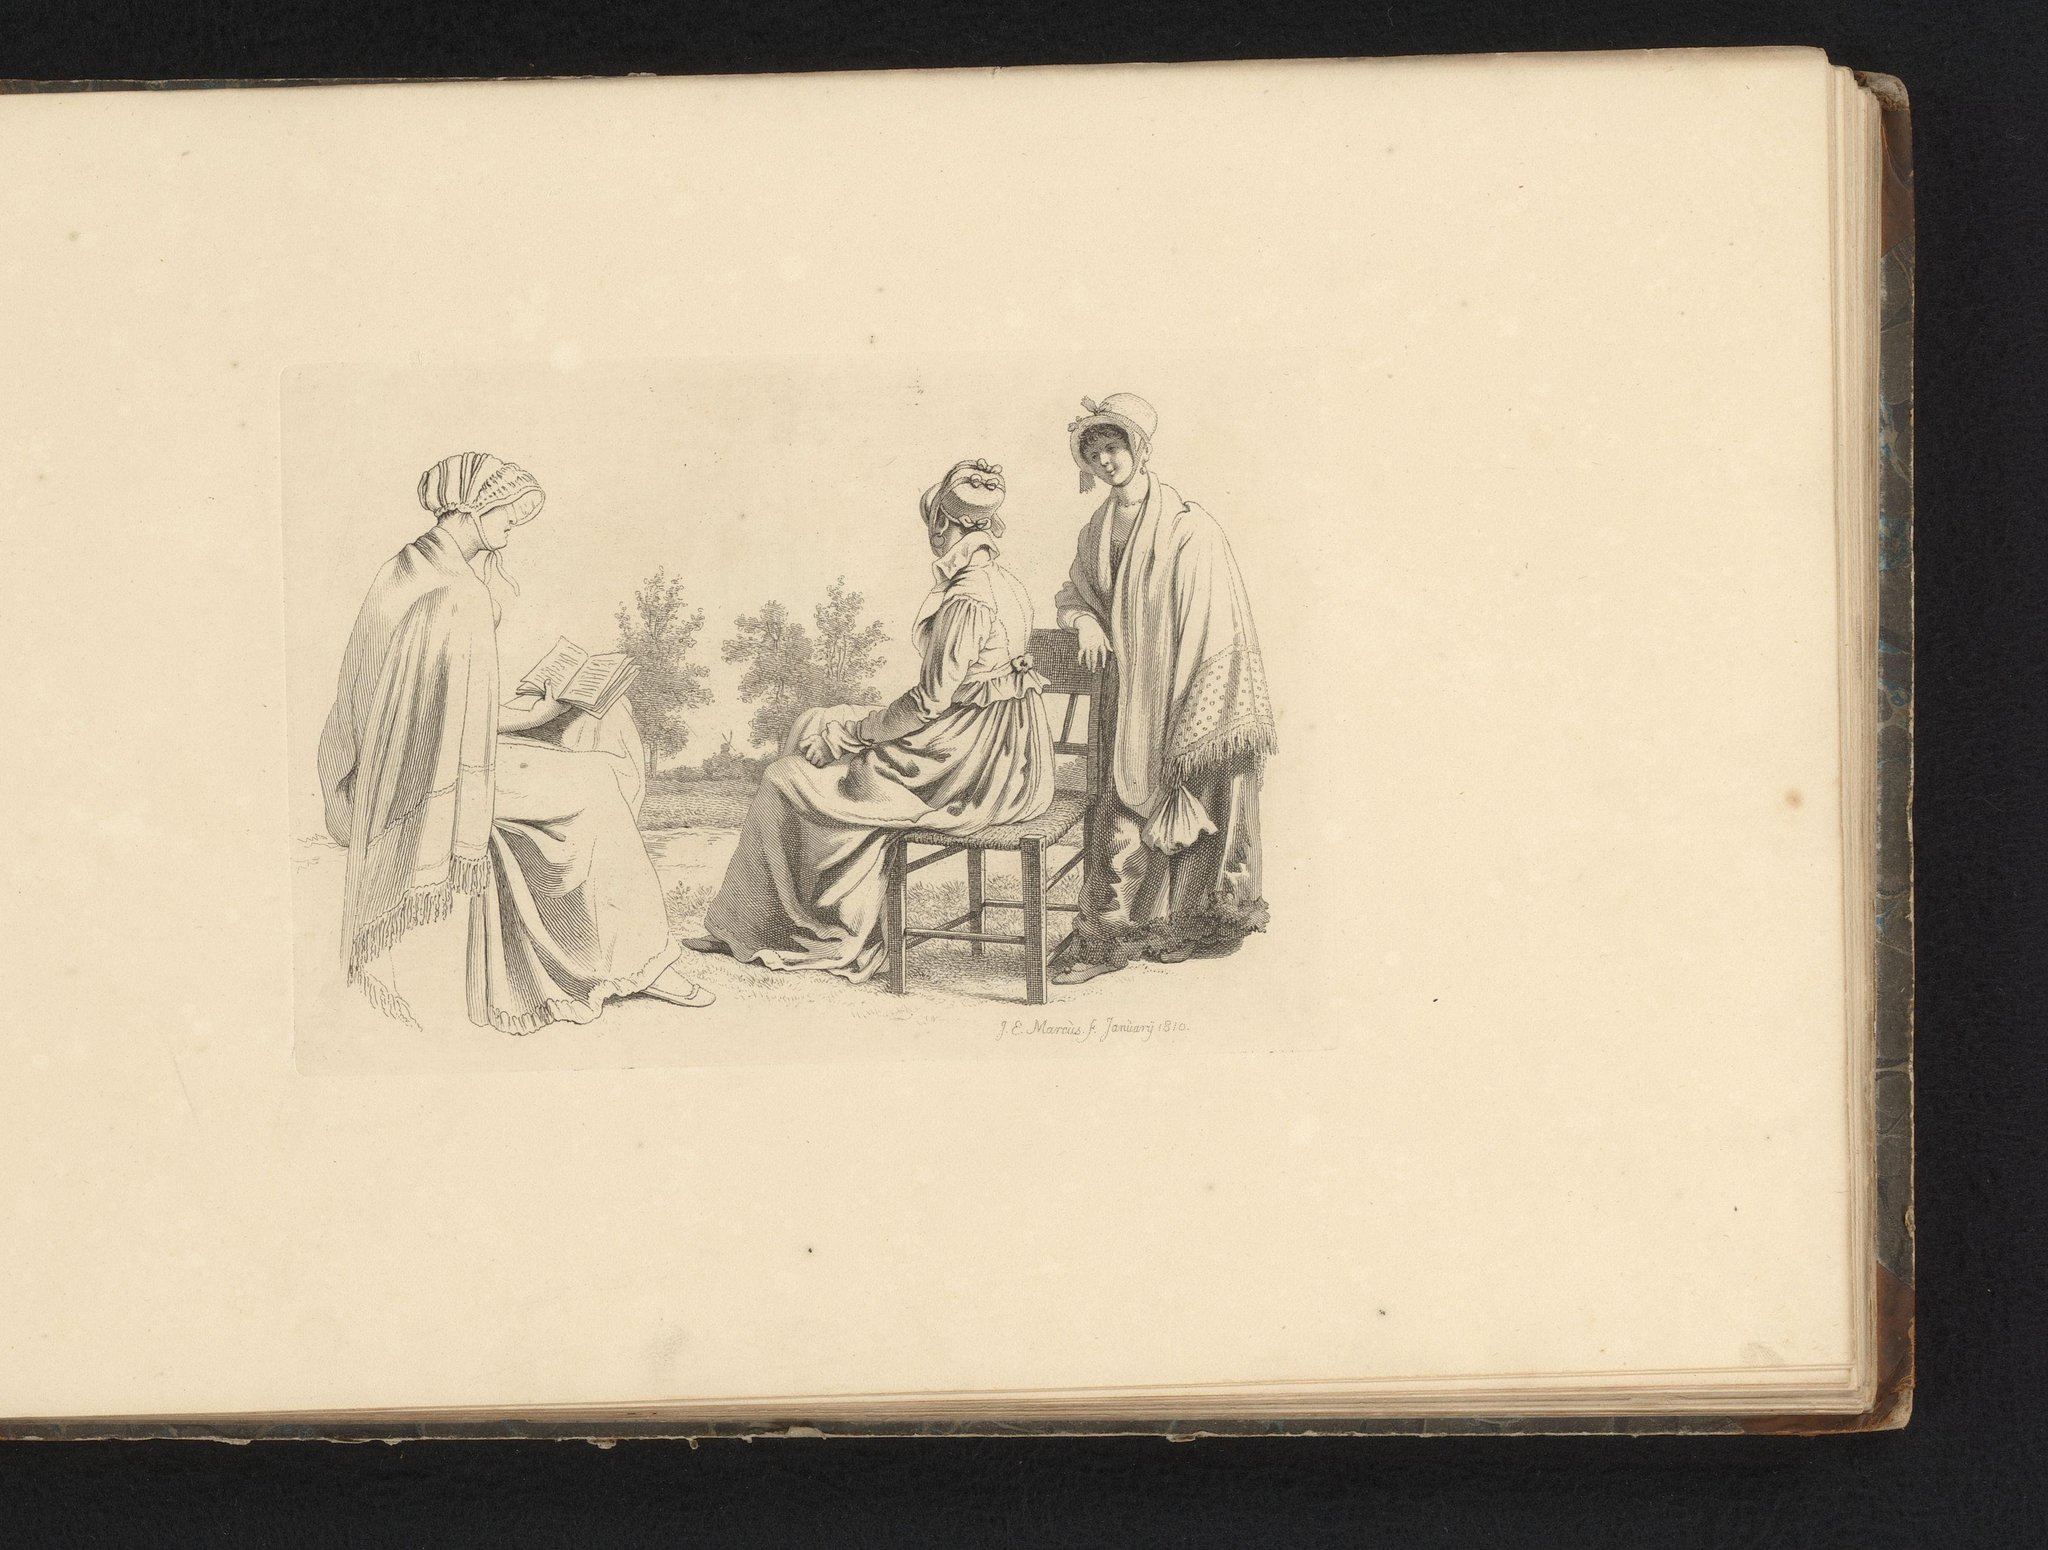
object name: print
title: Landschap met drie vrouwen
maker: jacob ernst marcus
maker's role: draughtsman, print maker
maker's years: 1774-1826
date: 1801-1810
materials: paper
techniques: etching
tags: reading, sitting figure - aa - female human figure, chair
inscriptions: date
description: Deze prent maakt deel uit van een album.